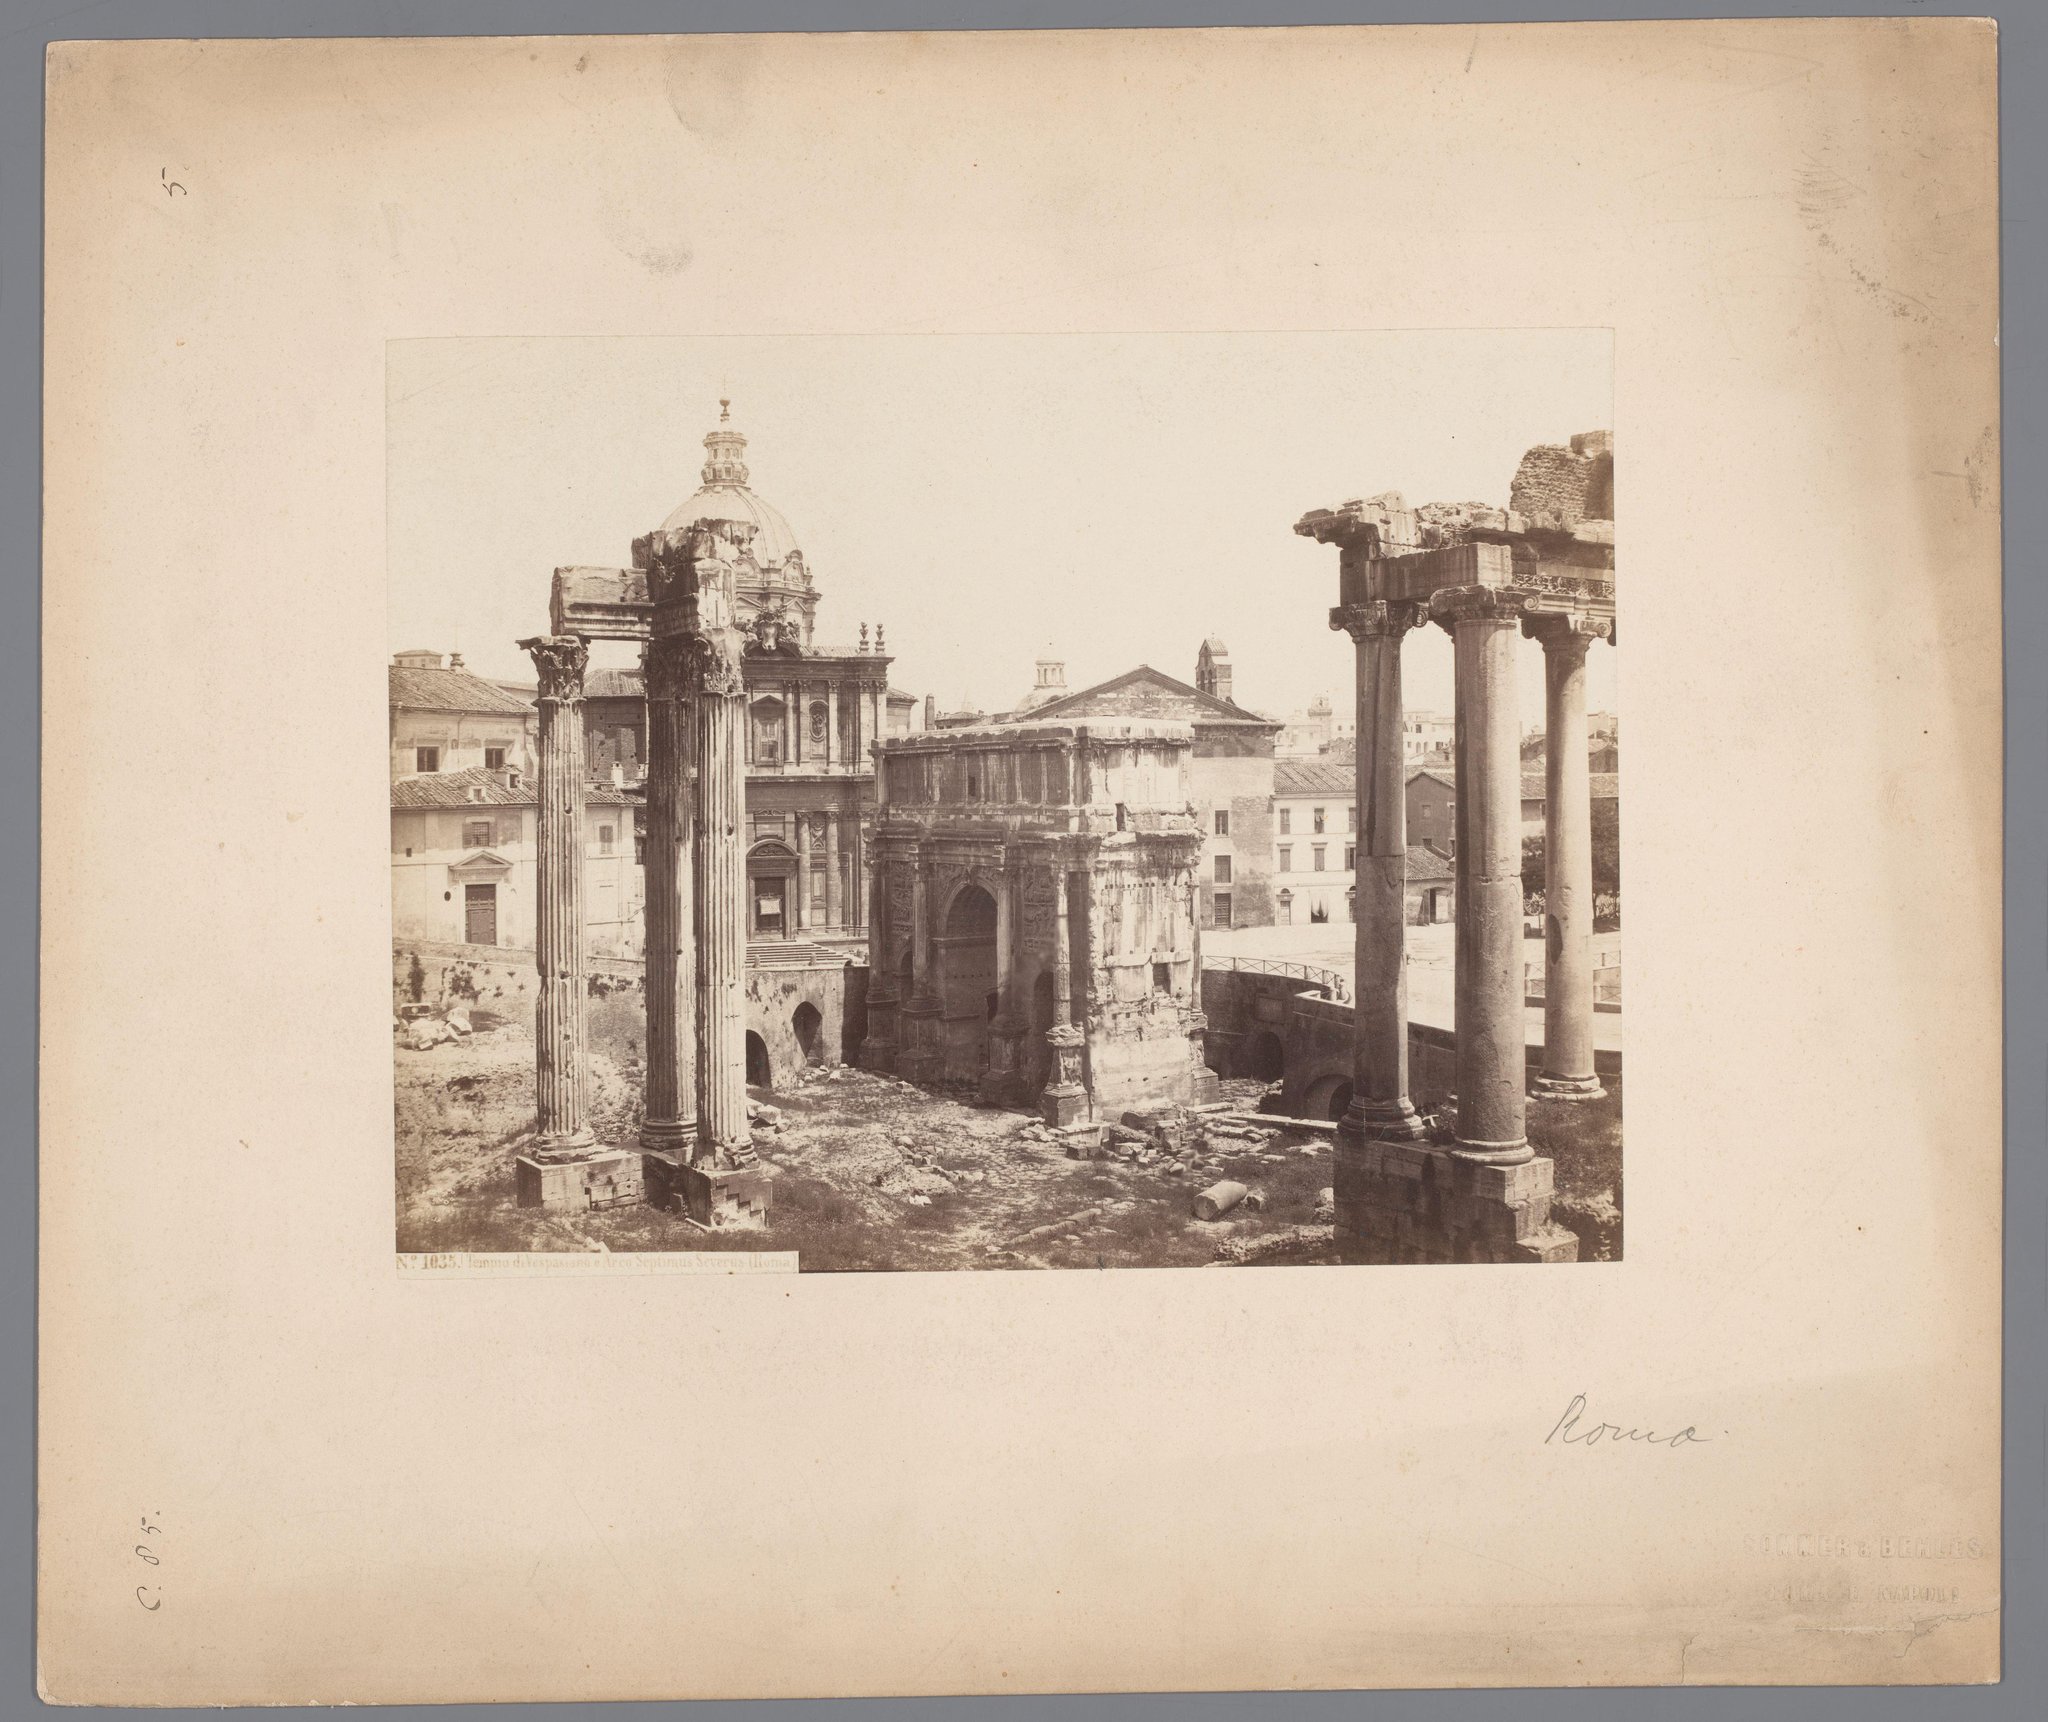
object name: photograph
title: Tempio di Vespasiano e Arco di Septimus Severus (Roma)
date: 1867-1874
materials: cardboard, paper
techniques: albumen print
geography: rome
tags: ruin of a building ~ architecture, triumphal arch, gate, entrance, scenes ~ anonymous historical person(s), rome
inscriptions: number: ‘No. 1035.’, inscription: ‘C. 85.’, address: ‘SOMMER & BEHLES/ ROMA E NAPOLI’, number: ‘5’, inscription: ‘Roma’